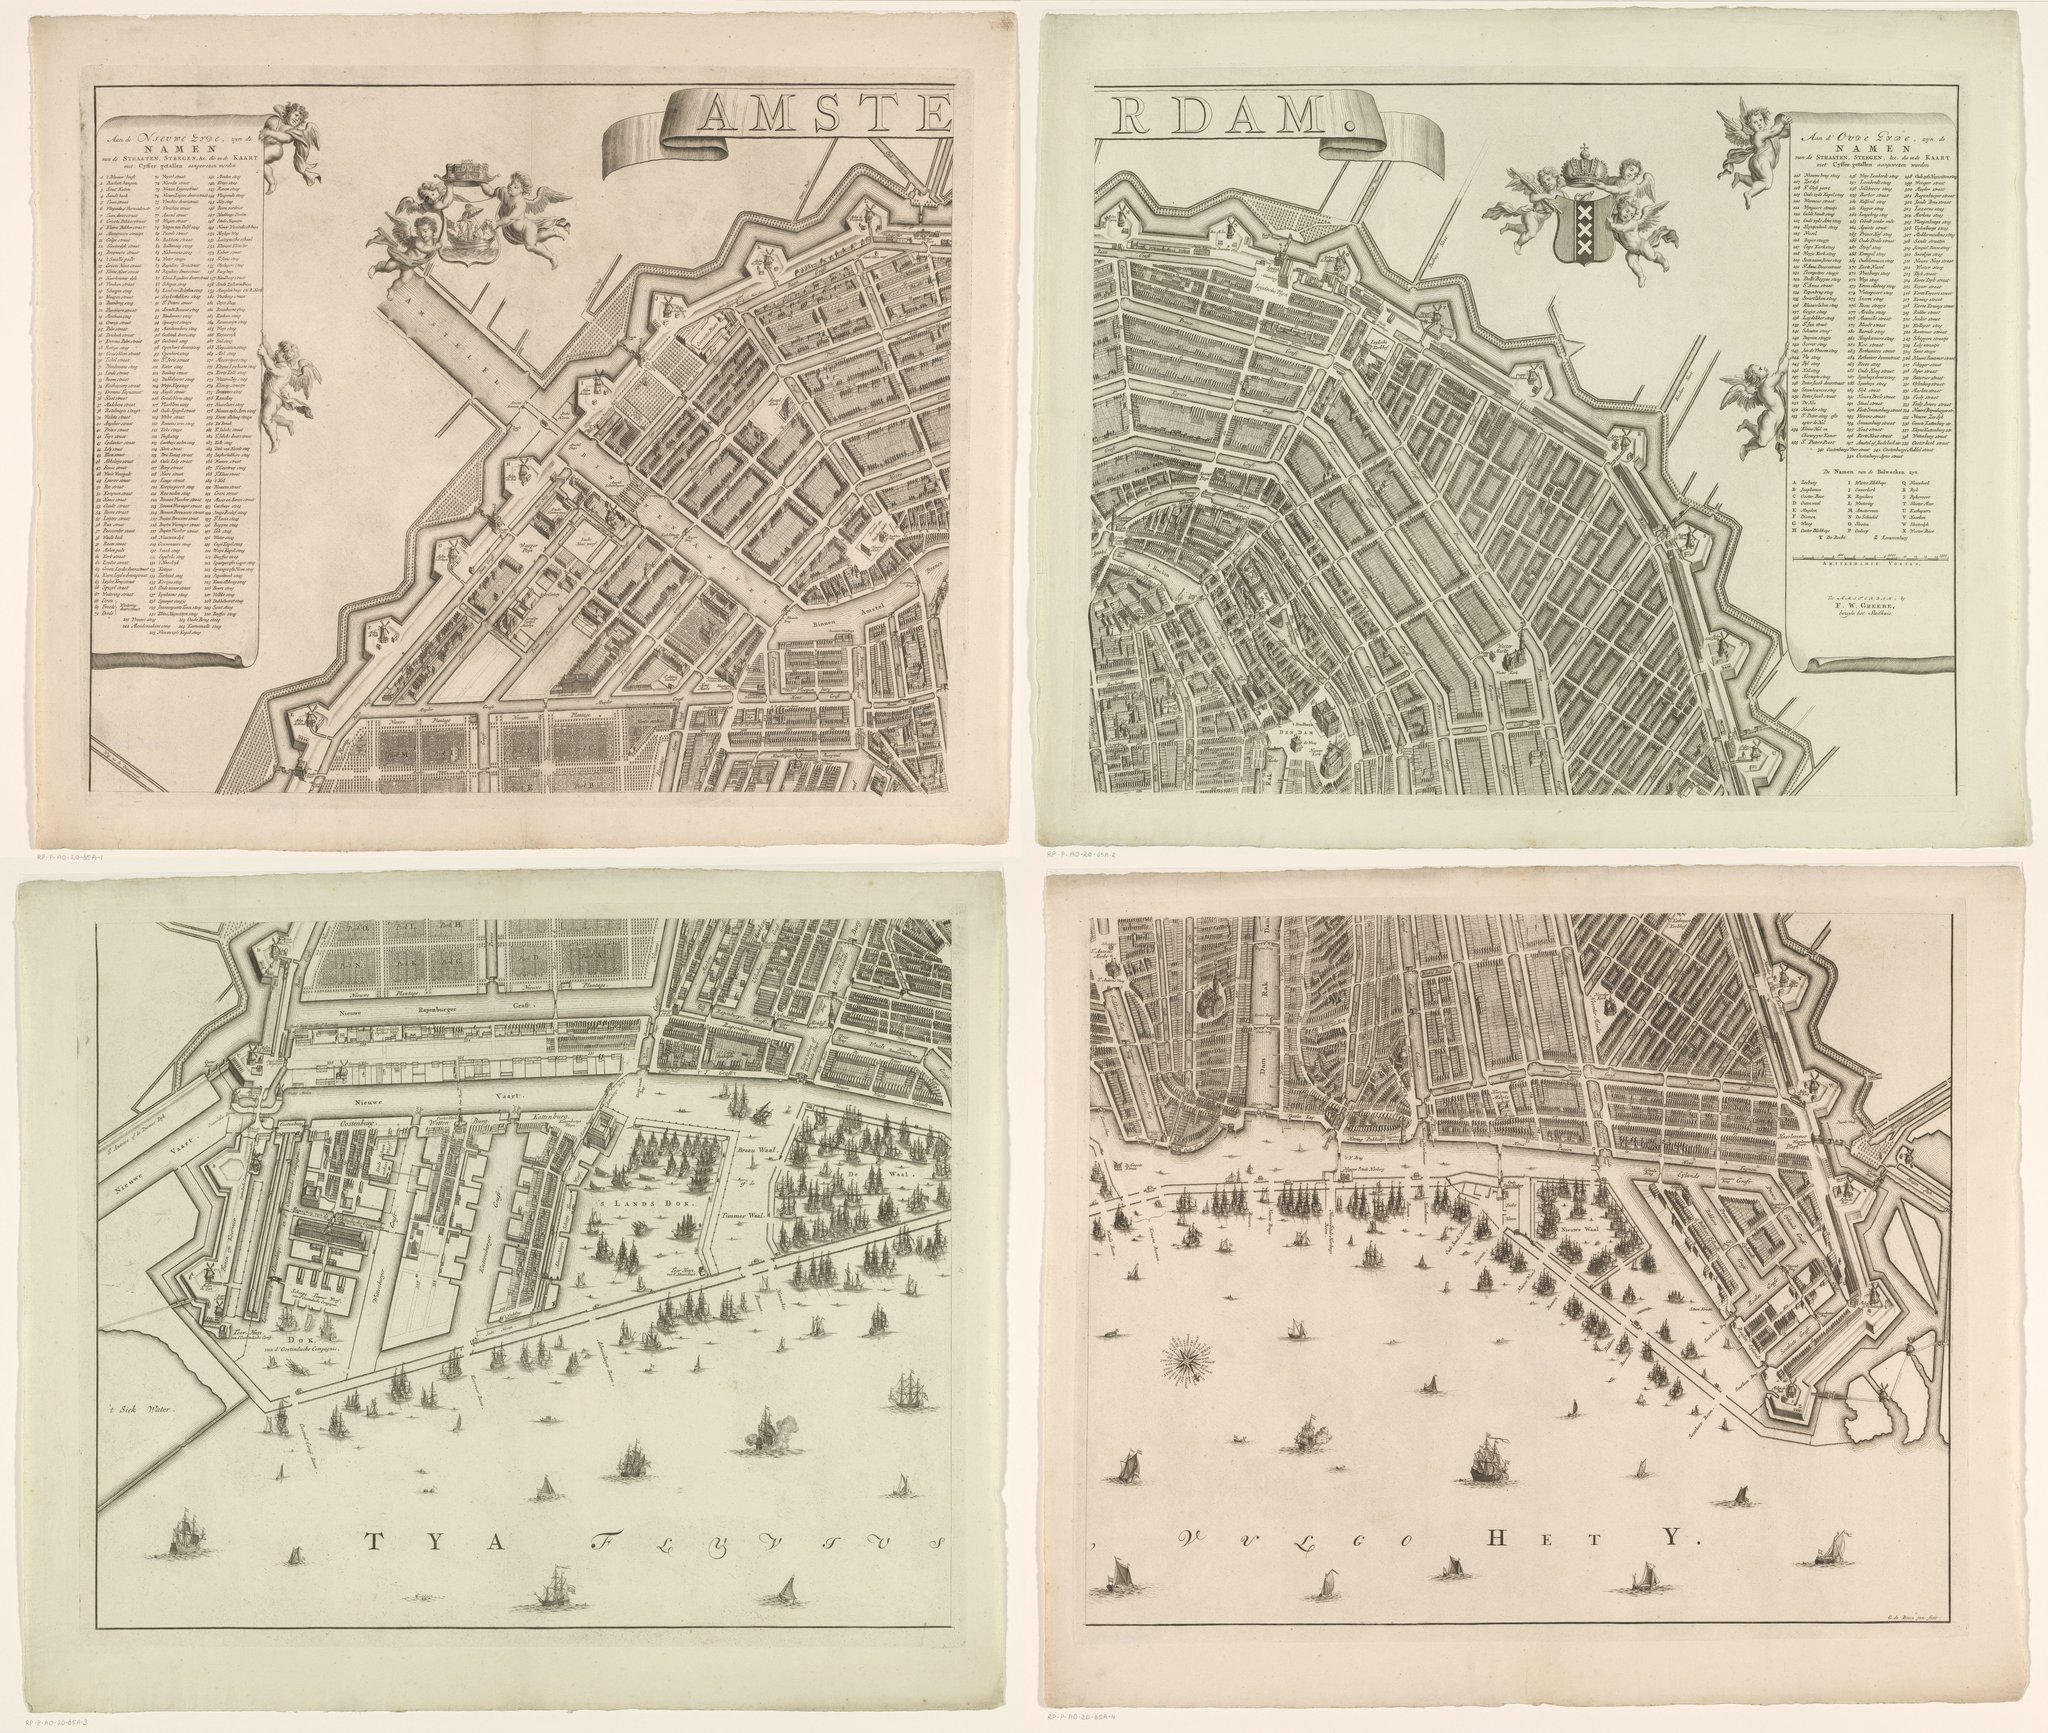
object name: print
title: Plattegrond van Amsterdam, bestaande uit vier delen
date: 1724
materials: paper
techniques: engraving, etching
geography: amsterdam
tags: coat of arms (as symbol of the state, etc.) (+ city; municipal), seal (as symbol of the state, etc.) (+ city; municipal), maps of cities, amsterdam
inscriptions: collector's mark: Lugt 2228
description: Plattegrond in vogelvluchtperspectief. Linksboven een cartouche met de legenda 1-215. Rechts daarvan het stadszegel. Boven in het midden een banderol met de titel. Rechtsboven een cartouche met de legenda 216-342, de legenda van de bolwerken A-Z en een schaalstok: 1500 Amsterdamse voeten. Links daarvan het wapen van de stad. Oriëntatie: zuidzuidwest boven.